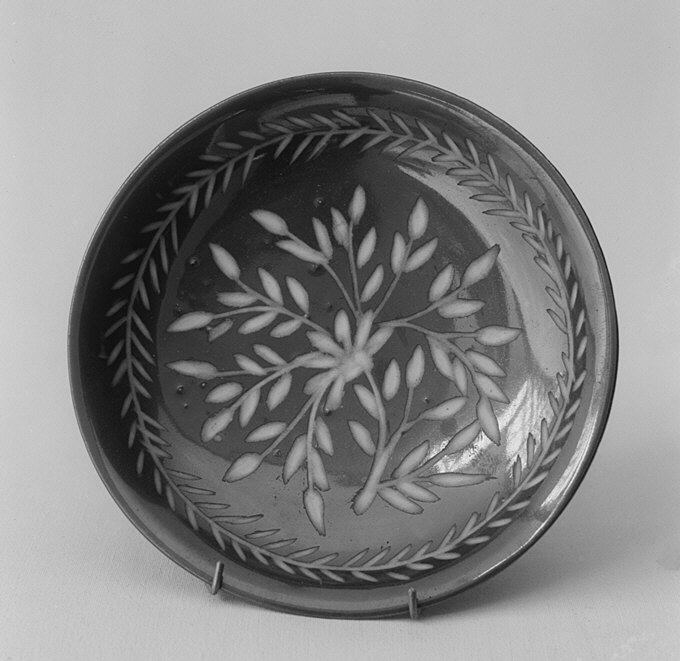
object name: saucer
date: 1734-1766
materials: hard paste porcelain